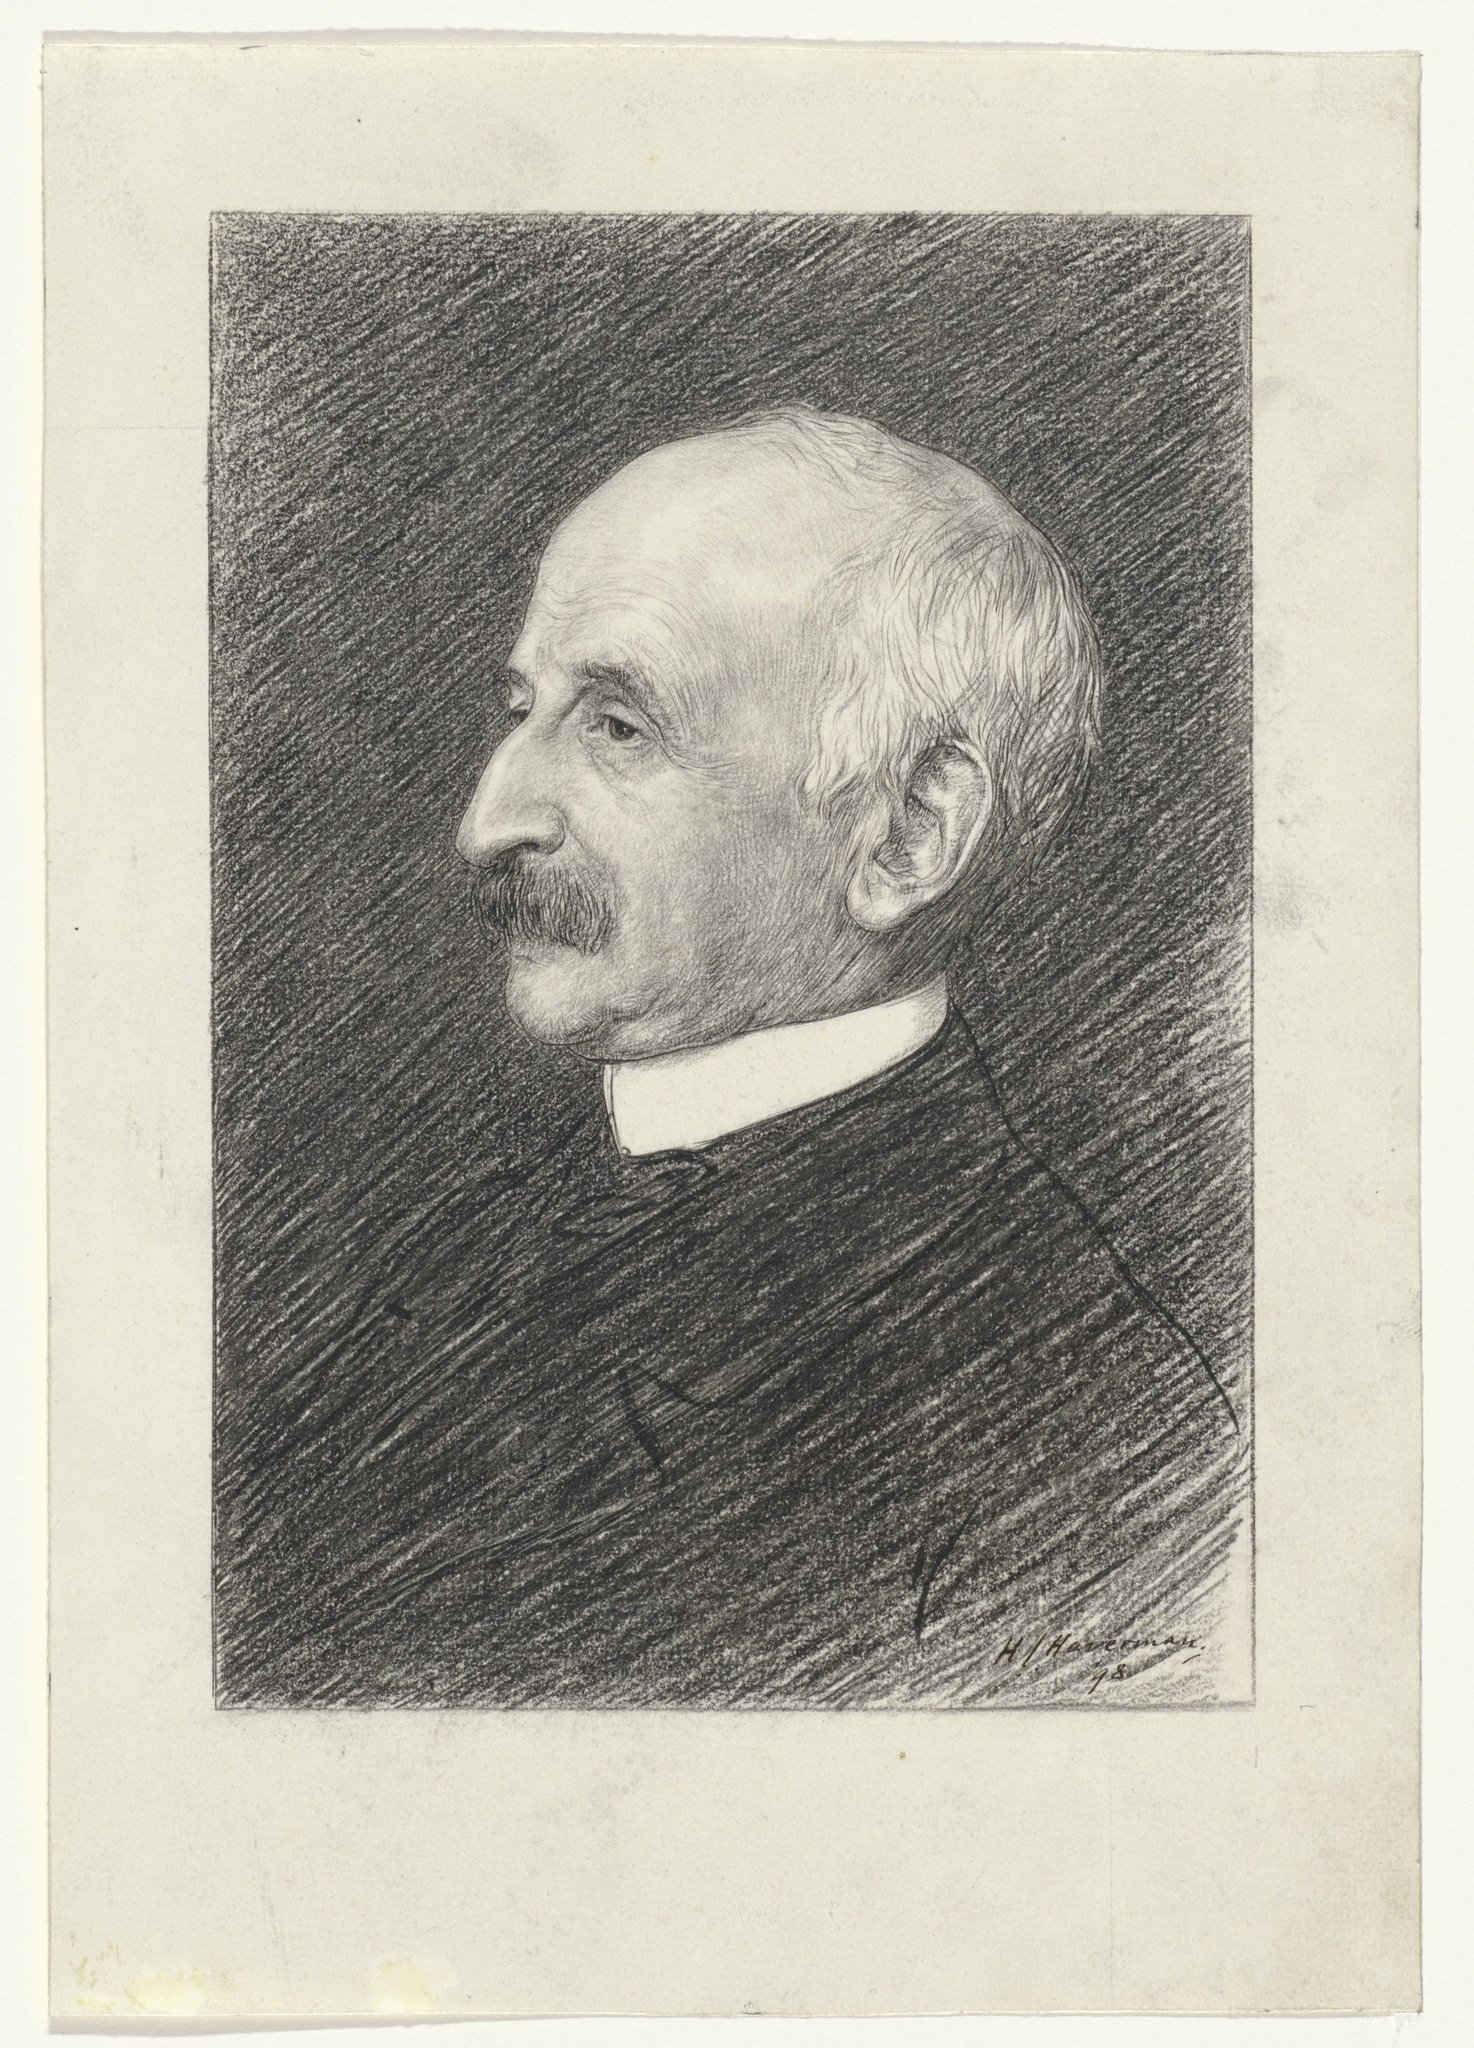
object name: drawing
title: Portret van professor T.M.C. Asser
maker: hendrik johannes haverman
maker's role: draughtsman, print maker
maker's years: 1857-1928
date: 1898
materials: chalk, paper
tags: amsterdam, the hague, historical persons